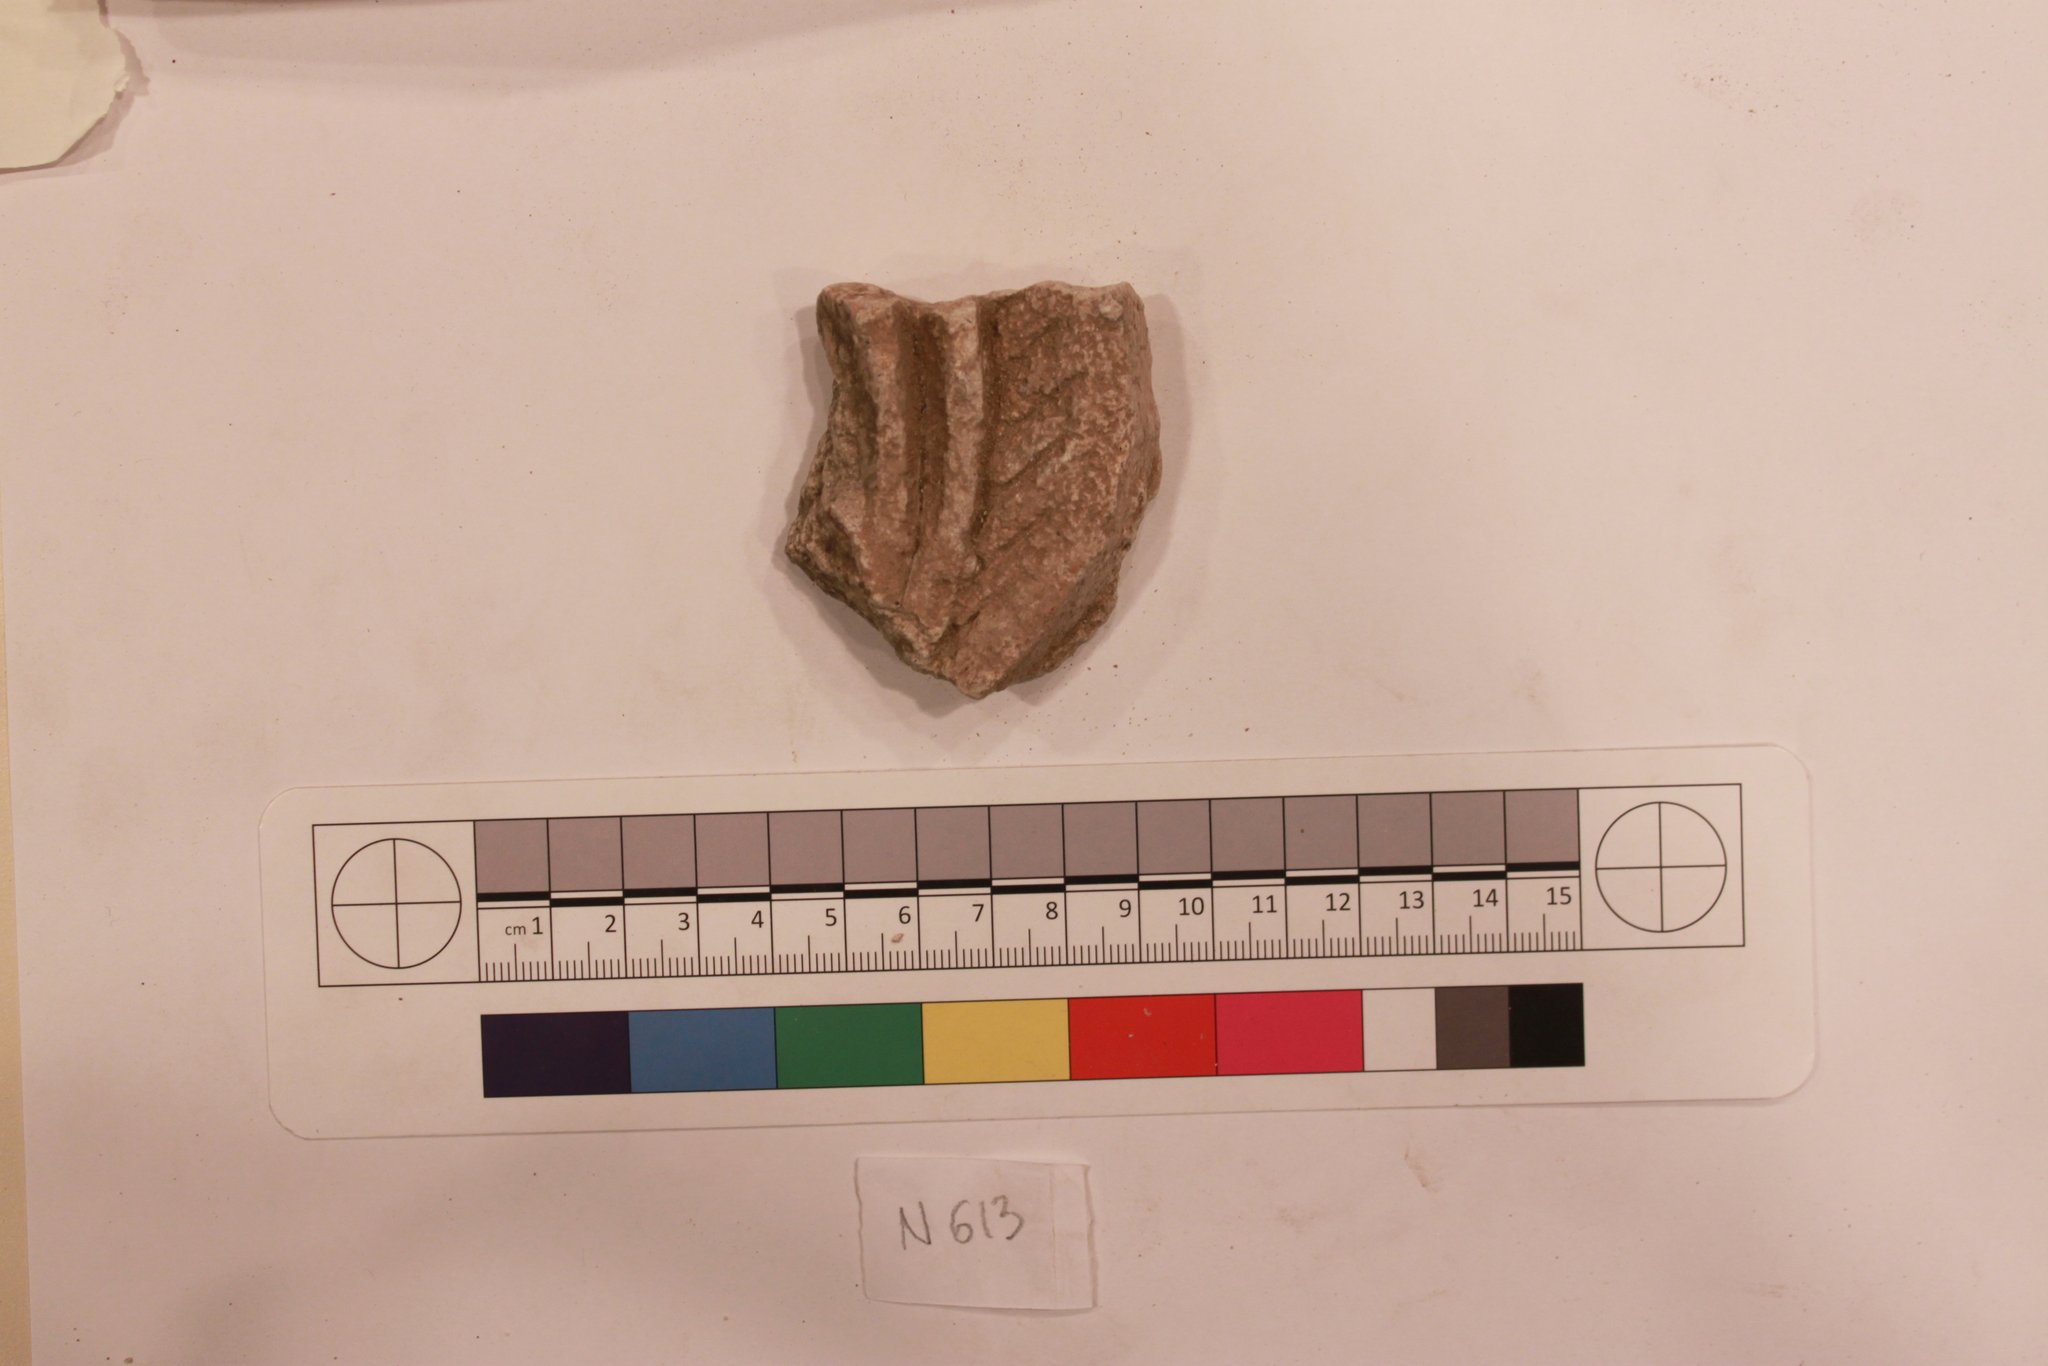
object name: fragment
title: Stucco Fragment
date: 701-1200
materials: plaster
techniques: carving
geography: iran